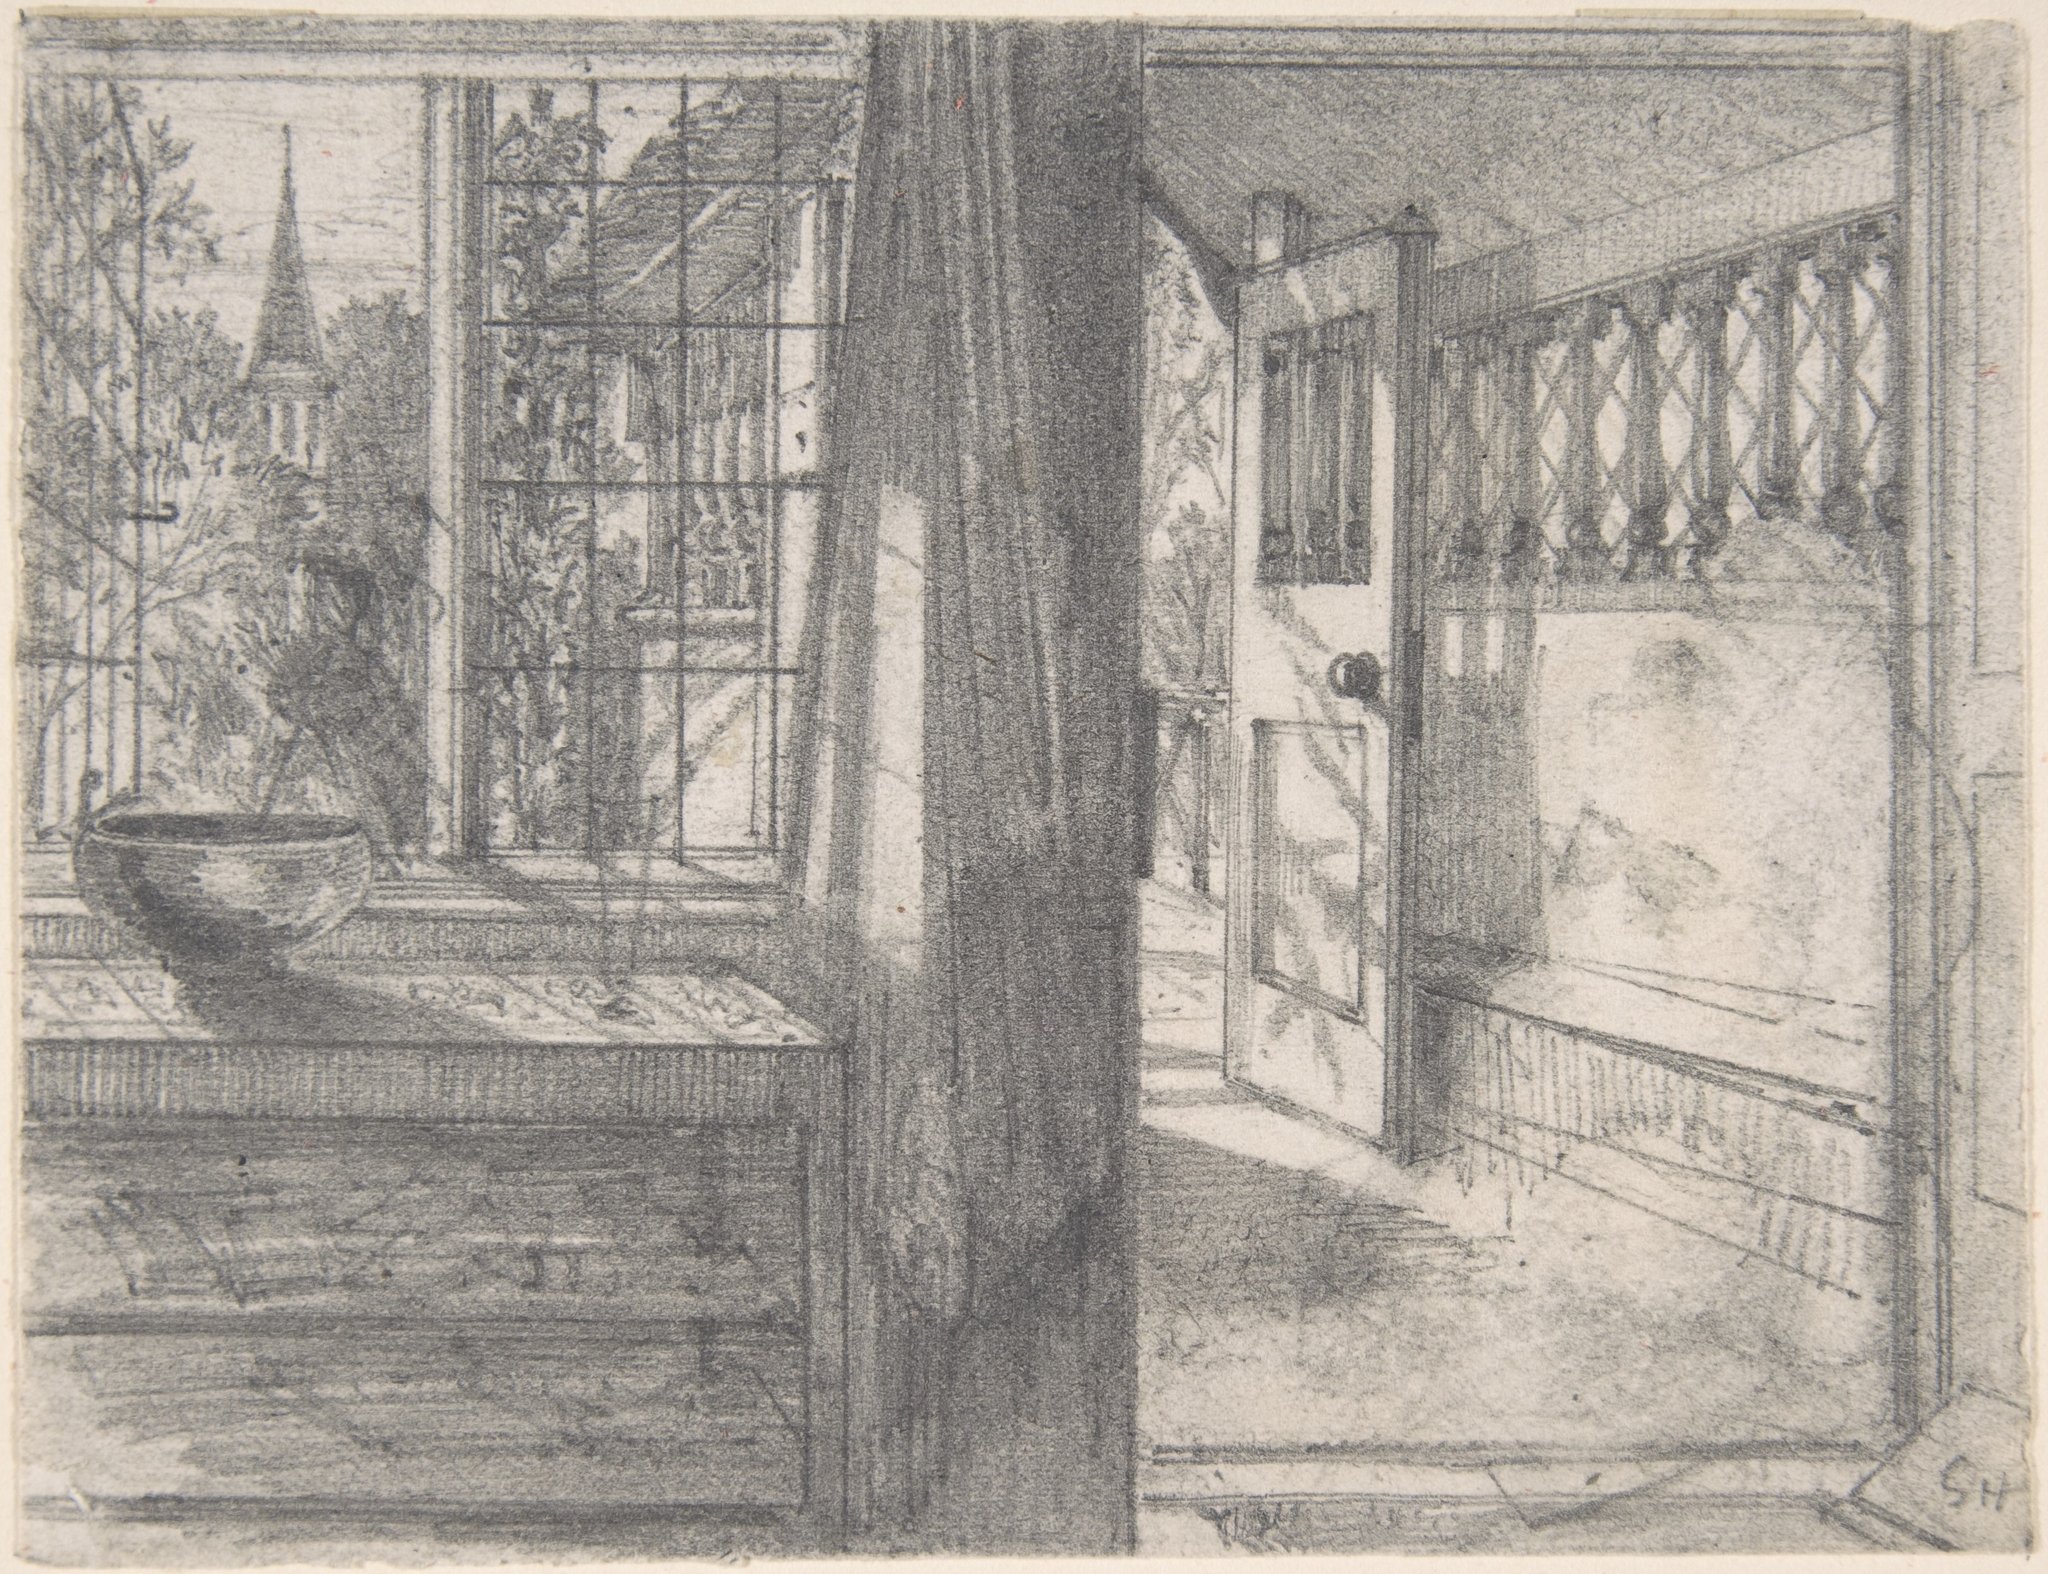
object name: drawing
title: A Cottage Porch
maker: francis seymour haden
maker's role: artist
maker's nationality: british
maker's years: 1818-1910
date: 1838-1910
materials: graphite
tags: doors,interiors